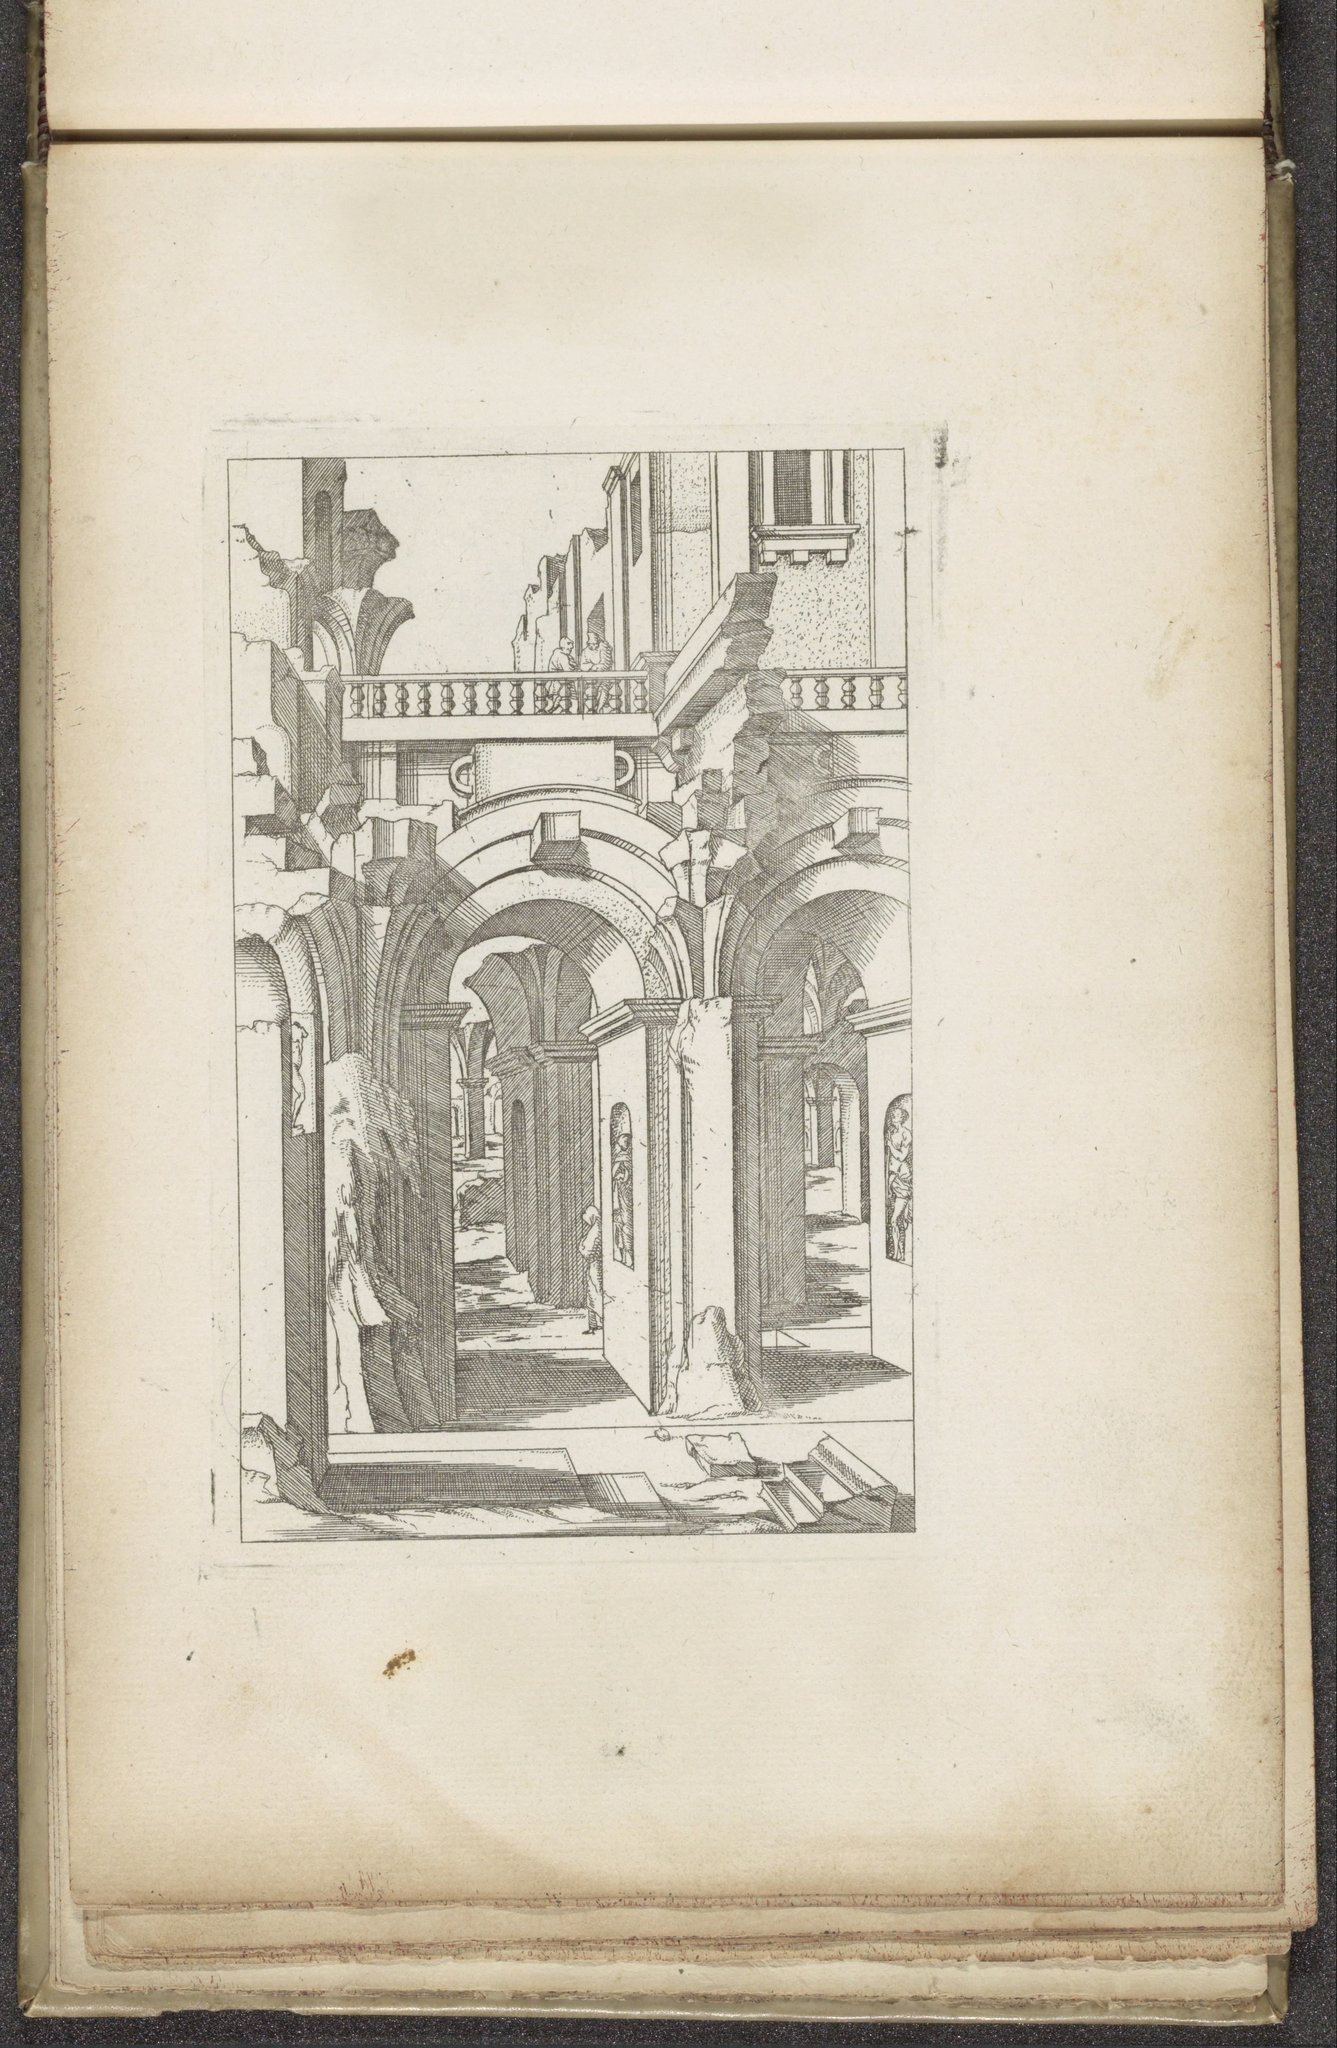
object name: album leaf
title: Ruïne van een meerbeukig gebouw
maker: jacques androuet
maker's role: draughtsman, print maker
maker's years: 1515-1584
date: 1550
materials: paper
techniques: etching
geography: orléans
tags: ruin of a building ~ architecture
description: Overblijfselen van een meerbeukig gebouw. Op de eerste verdieping leunen twee mannen over de balustrade. Deze prent maakt deel uit van een album.